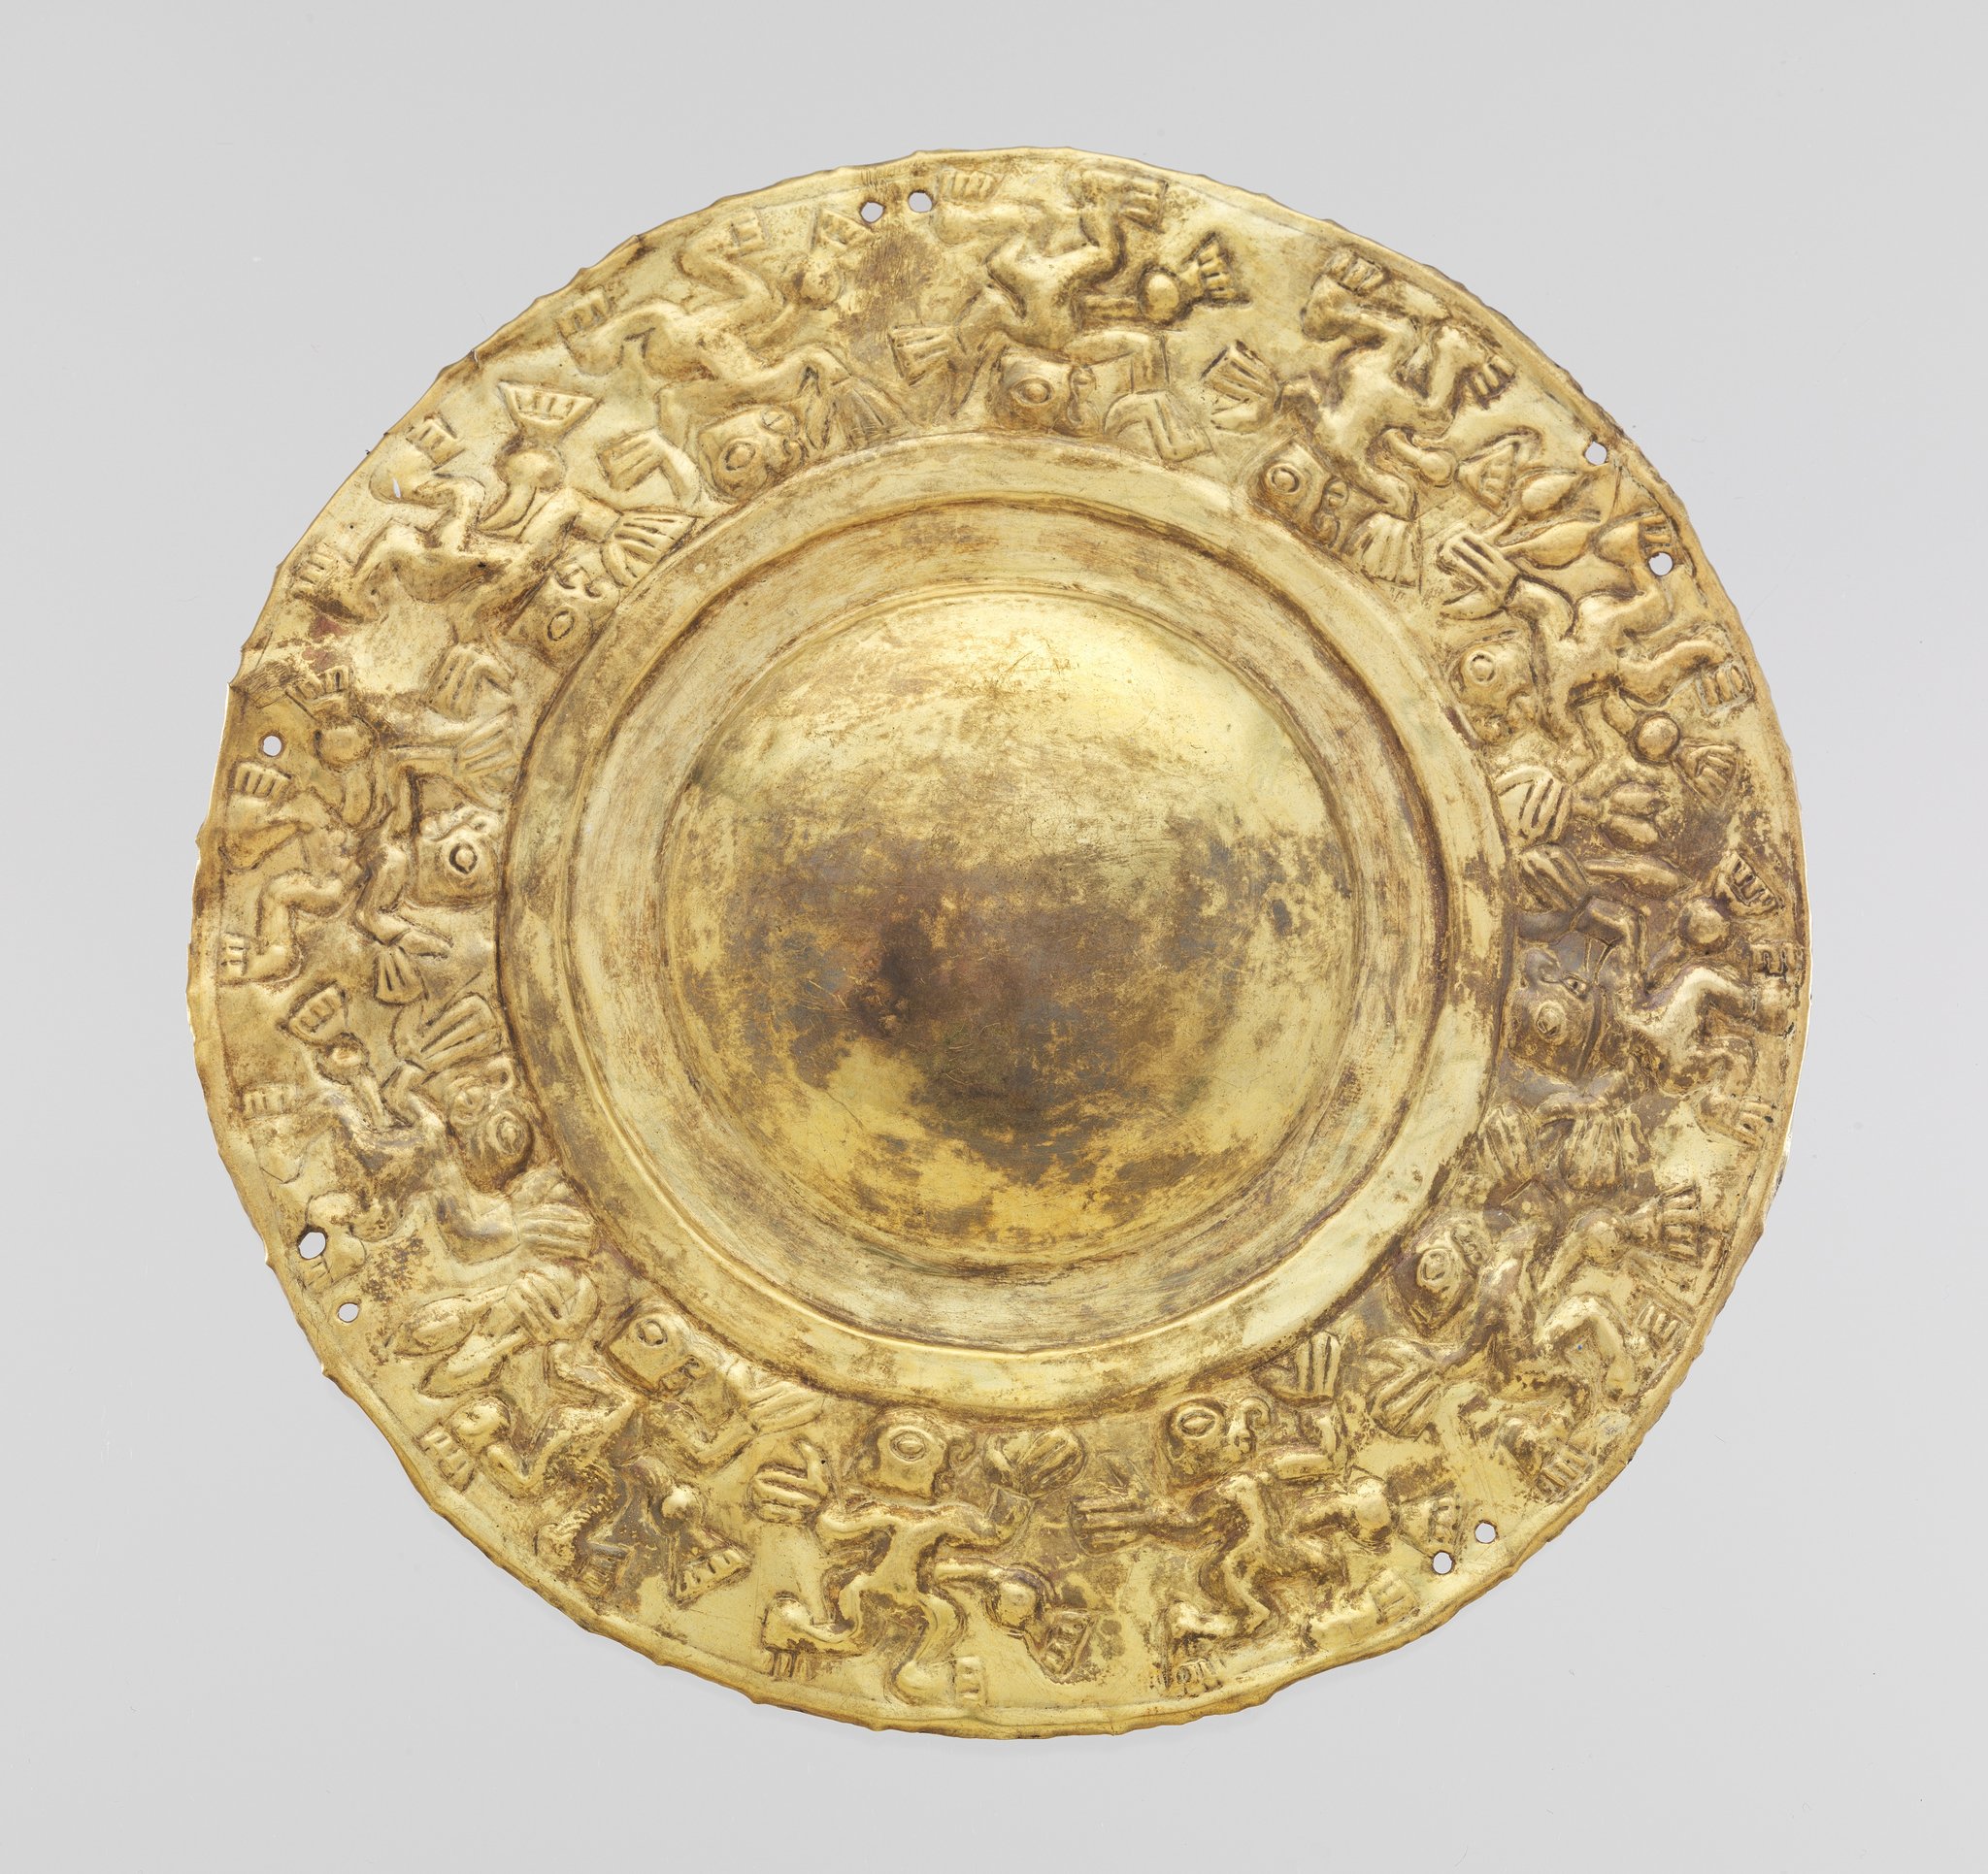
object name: disk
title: Ornamental disk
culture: chimú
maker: chimú artist(s)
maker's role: artist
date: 1100-1470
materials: gold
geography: peru